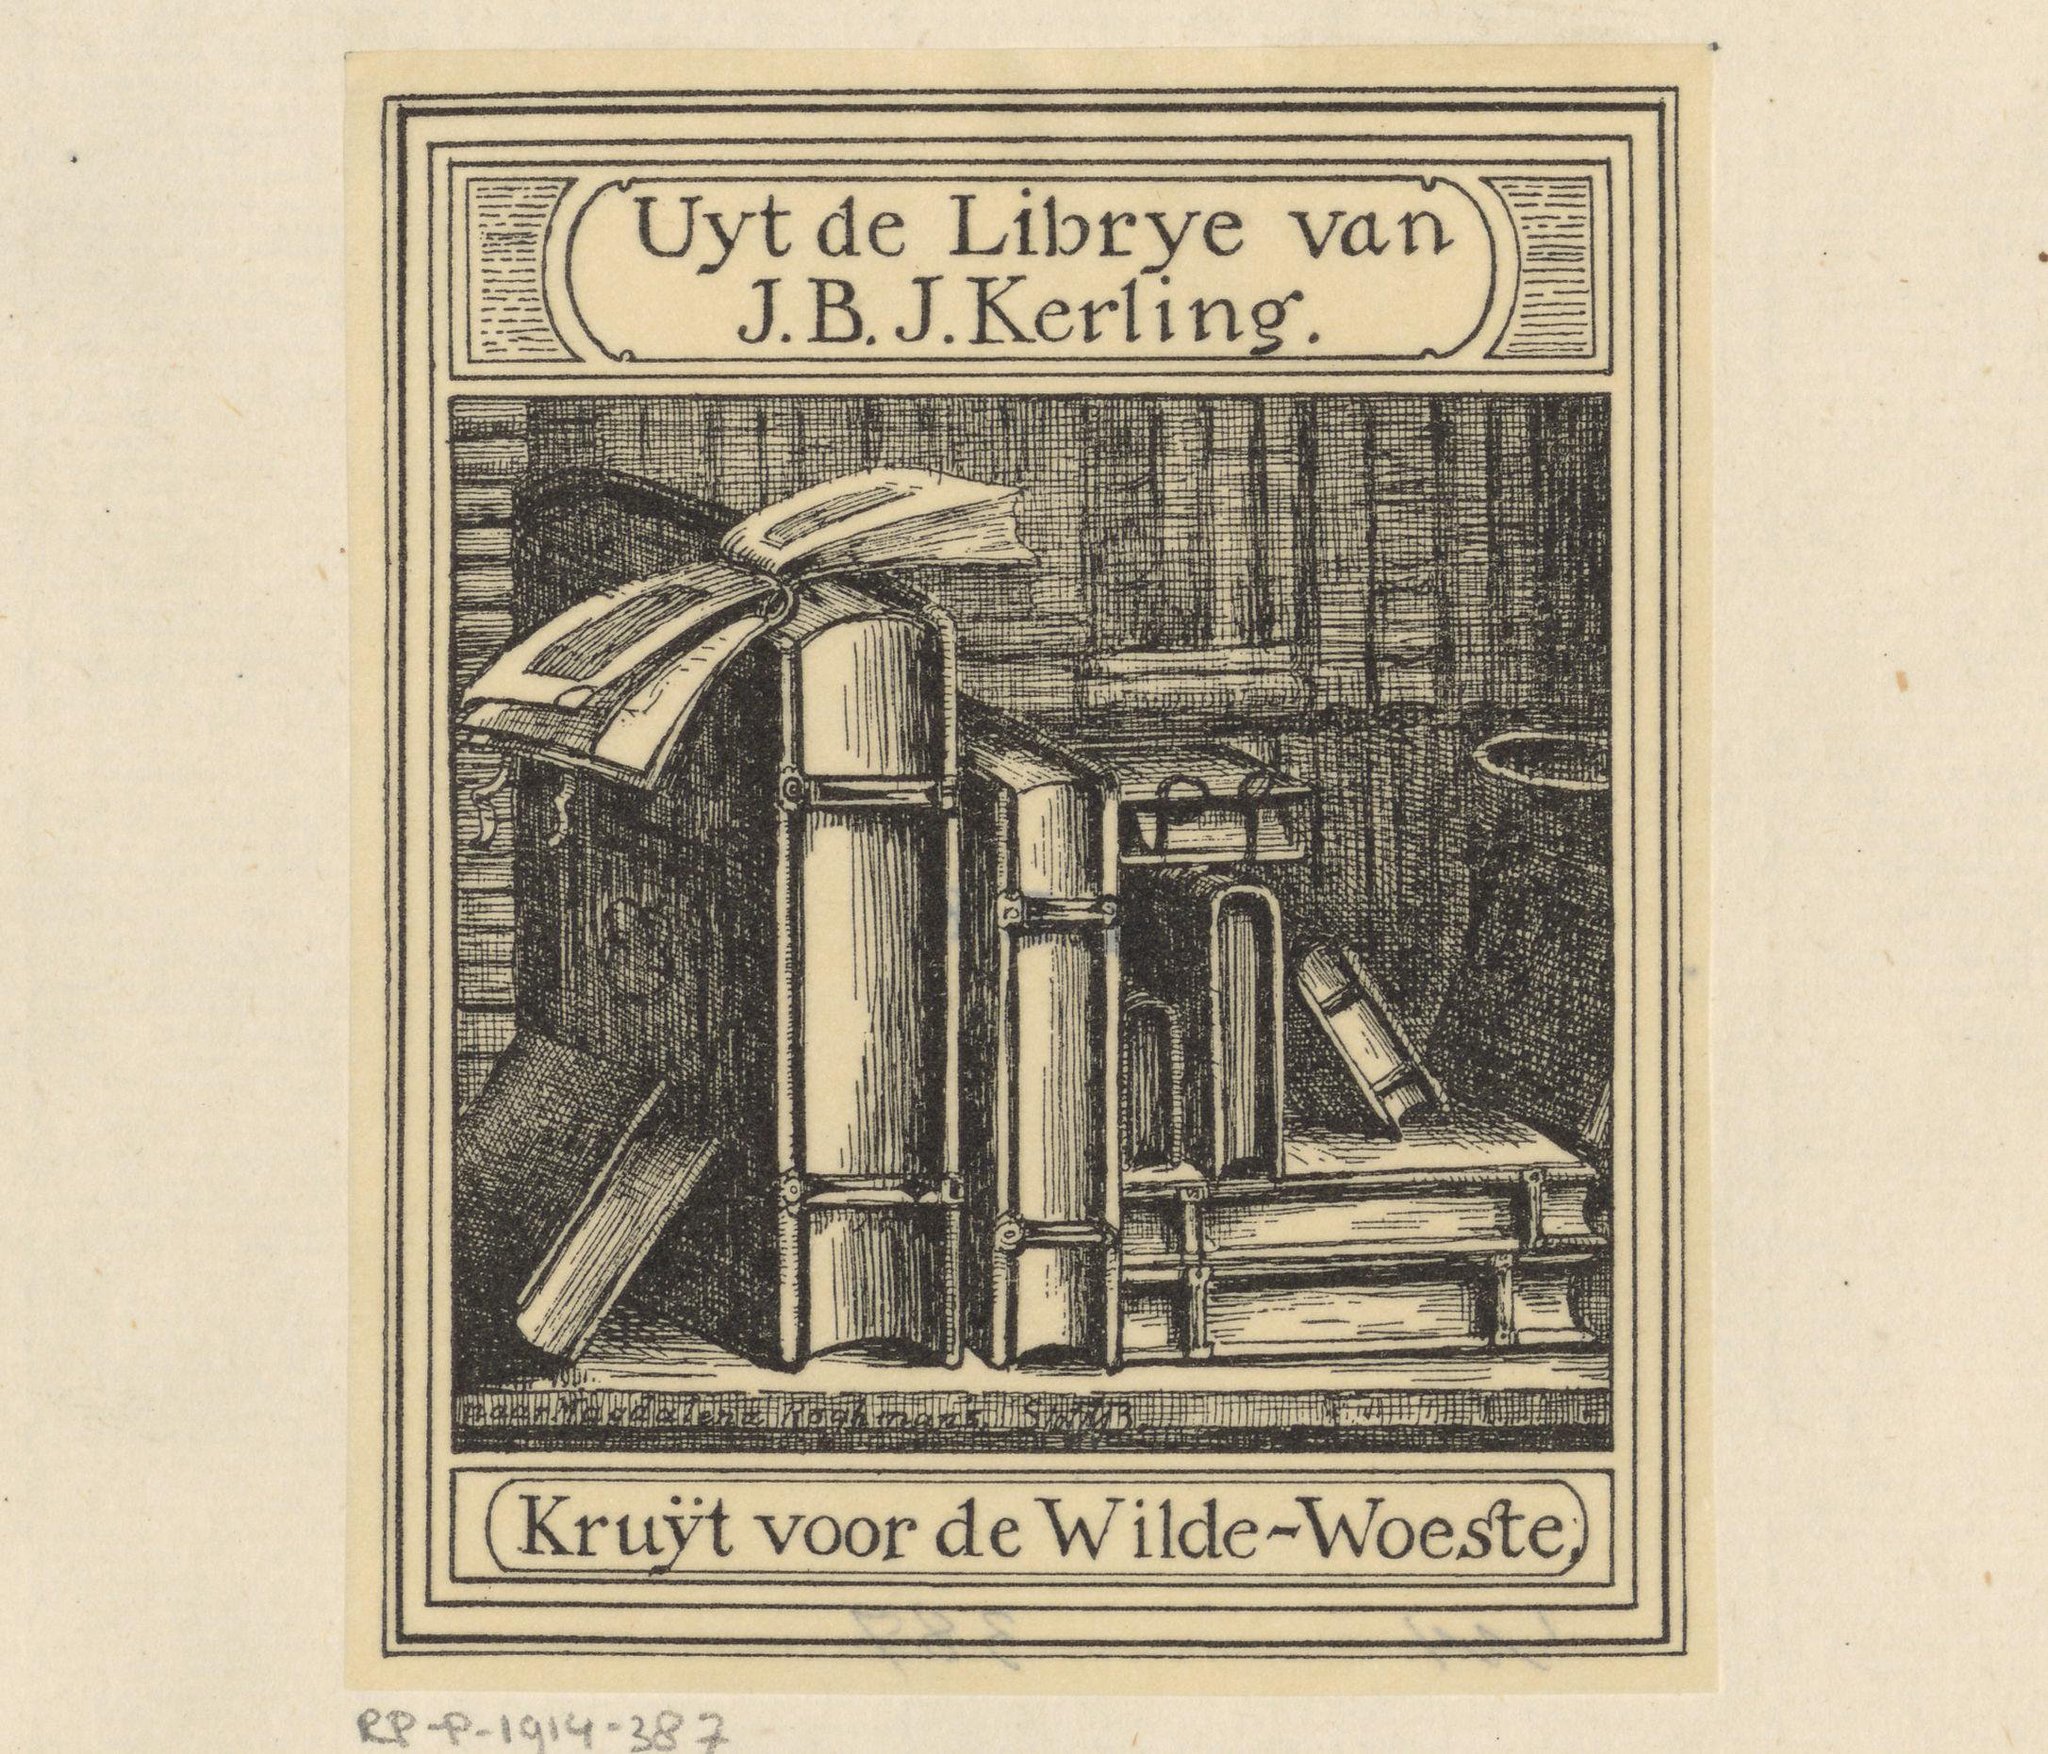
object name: bookplate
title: Ex libris van J.B.I. Kerling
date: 1881-1914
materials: paper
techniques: printing block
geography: netherlands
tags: j.b.j. kerling, antique dealer, book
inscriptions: collector's mark: Lugt 2233